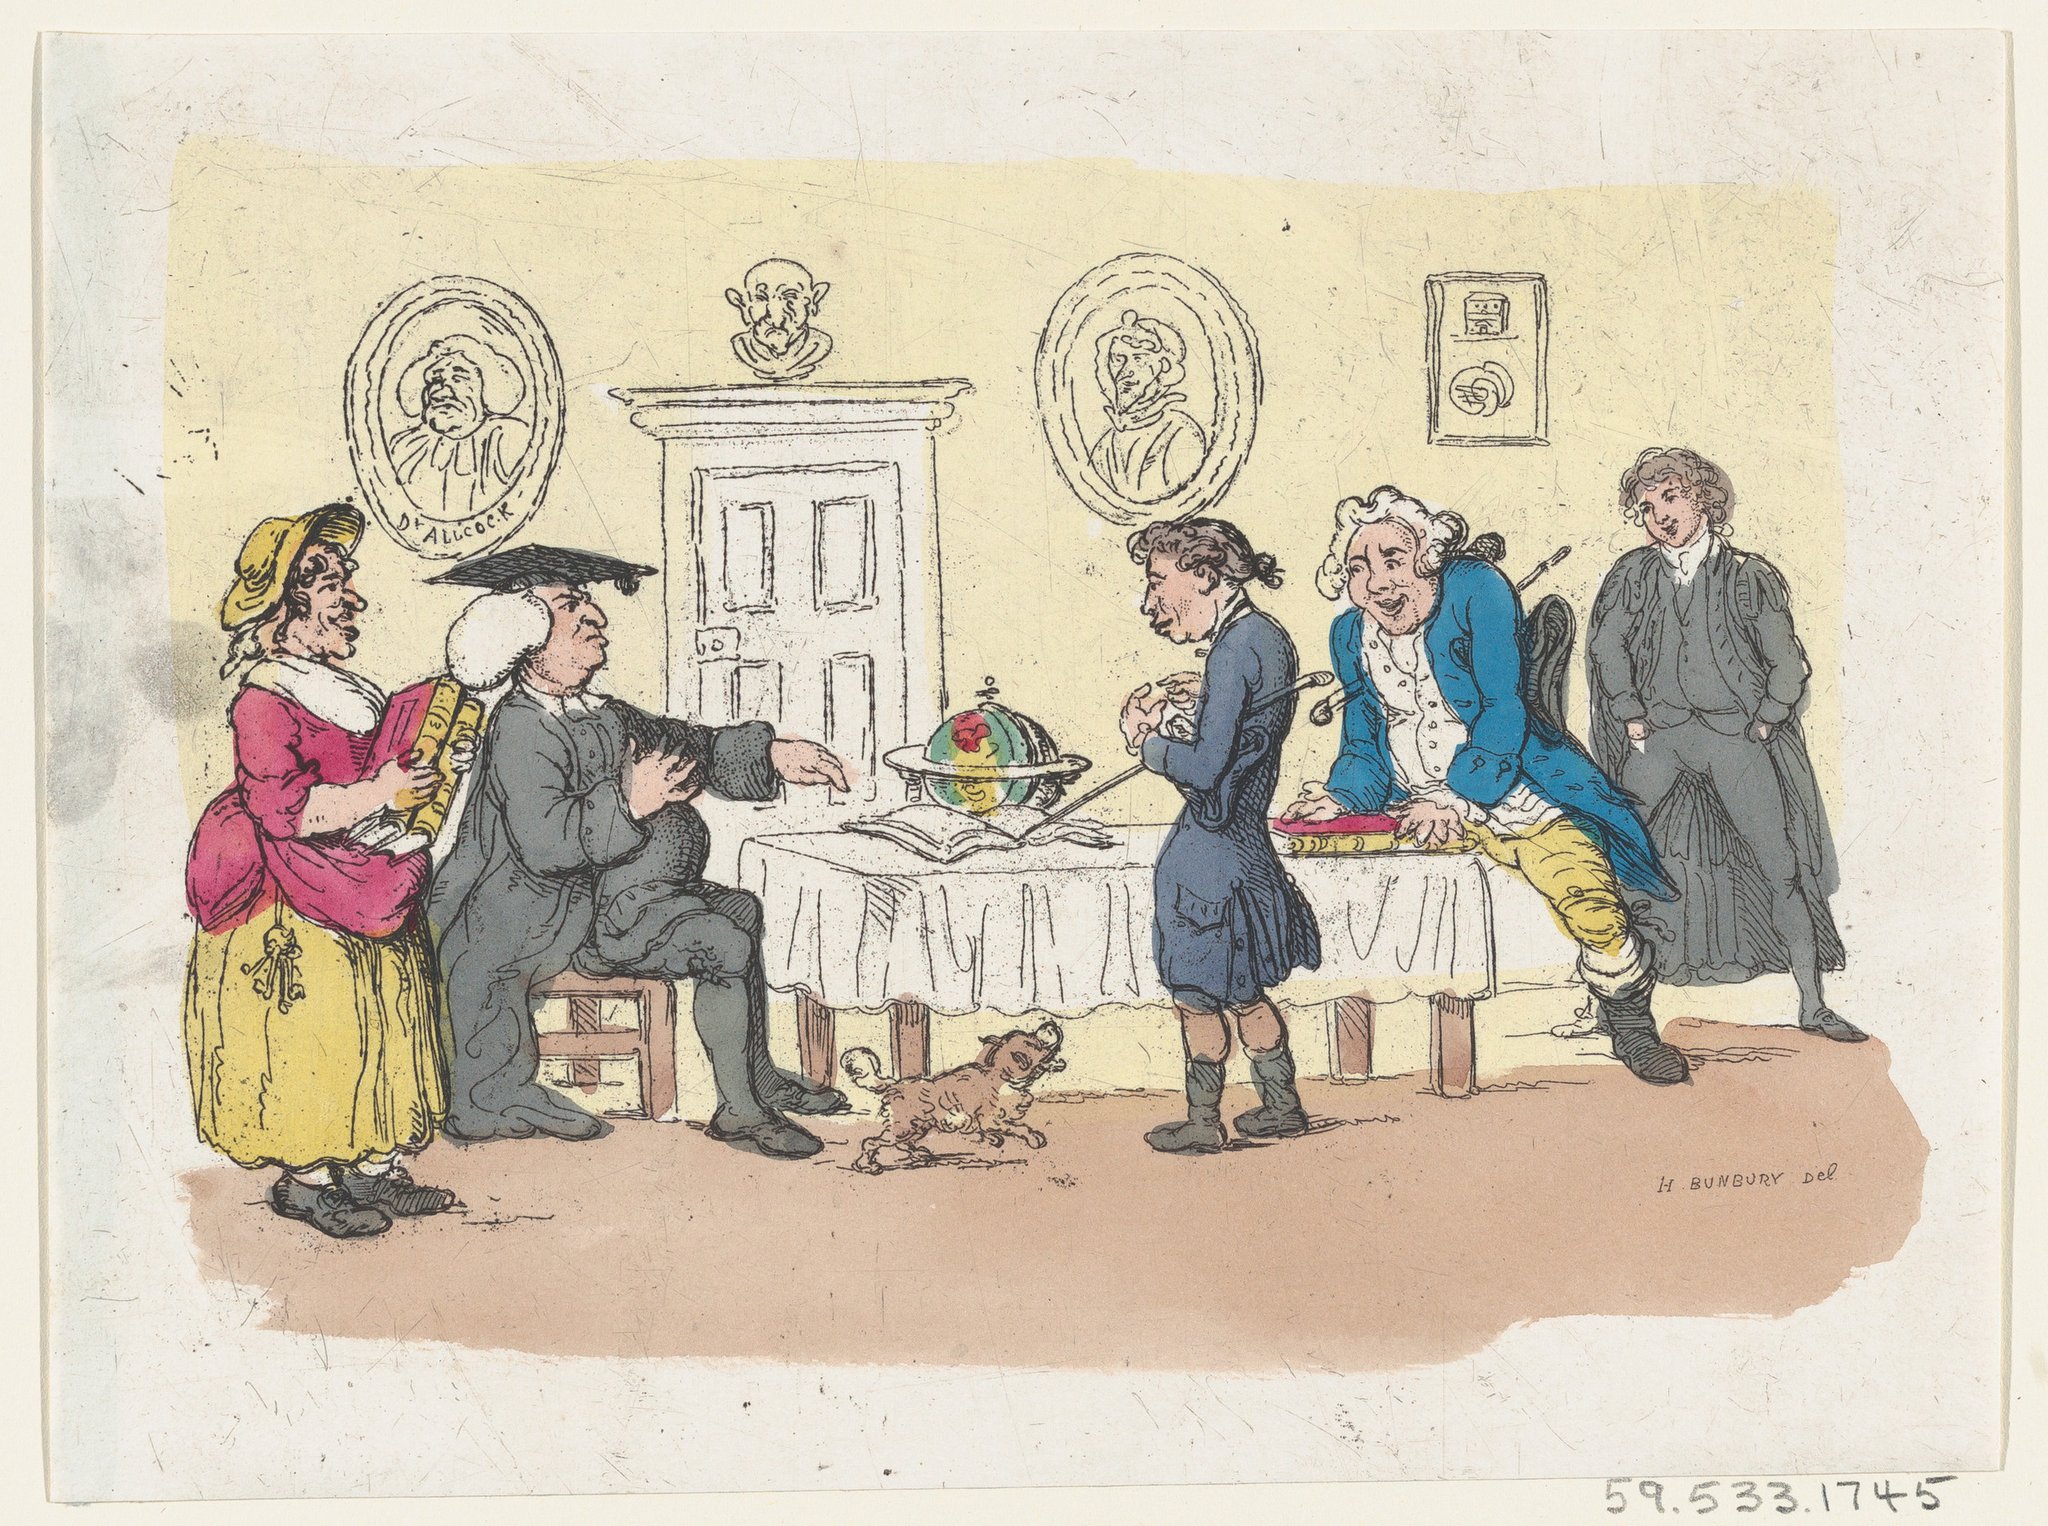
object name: print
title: The Hopes of the Family – An Admission at the University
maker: thomas rowlandson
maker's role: artist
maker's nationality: british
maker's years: 1757-1827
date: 1803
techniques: etching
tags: satire,men,women,dogs,students